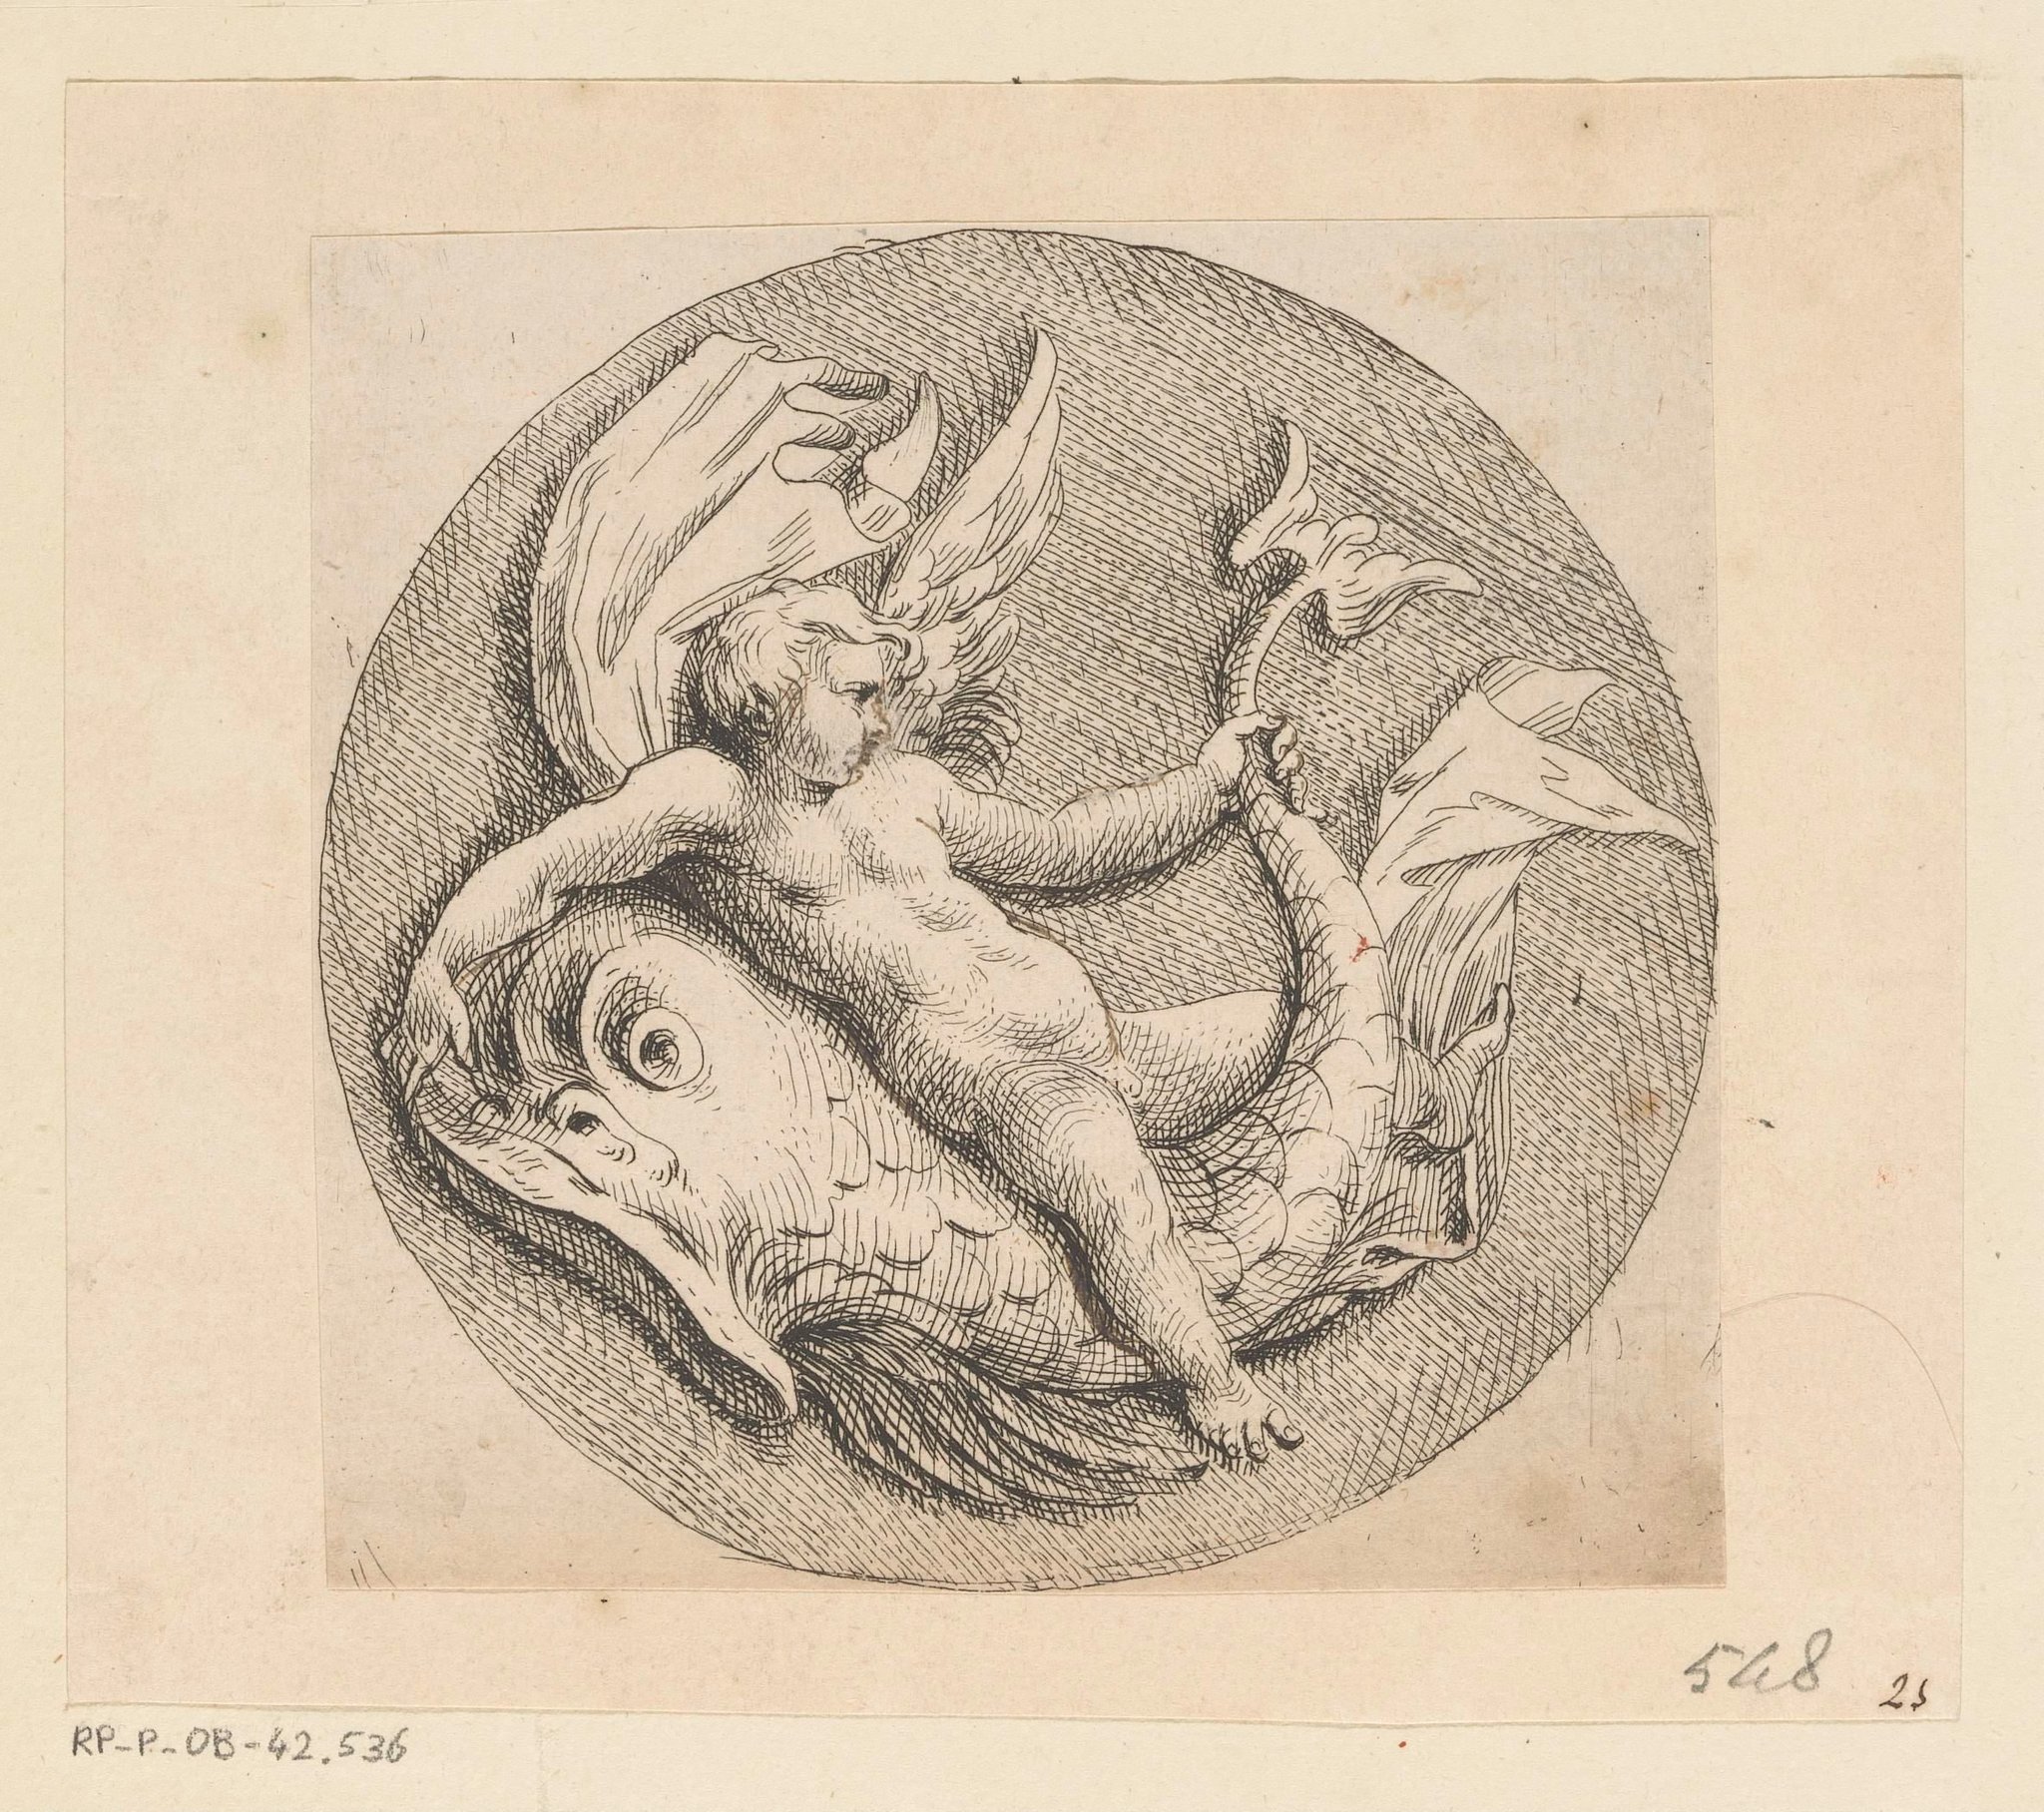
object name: print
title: Putto zittend op een vis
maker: anne claude philippe caylus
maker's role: print maker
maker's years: 1692-1765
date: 1702-1765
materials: paper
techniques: etching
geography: france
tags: fabulous animals ~ fishes, cupids: 'amores', 'amoretti', 'putti'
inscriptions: collector's mark: Lugt 240, number: ‘25’